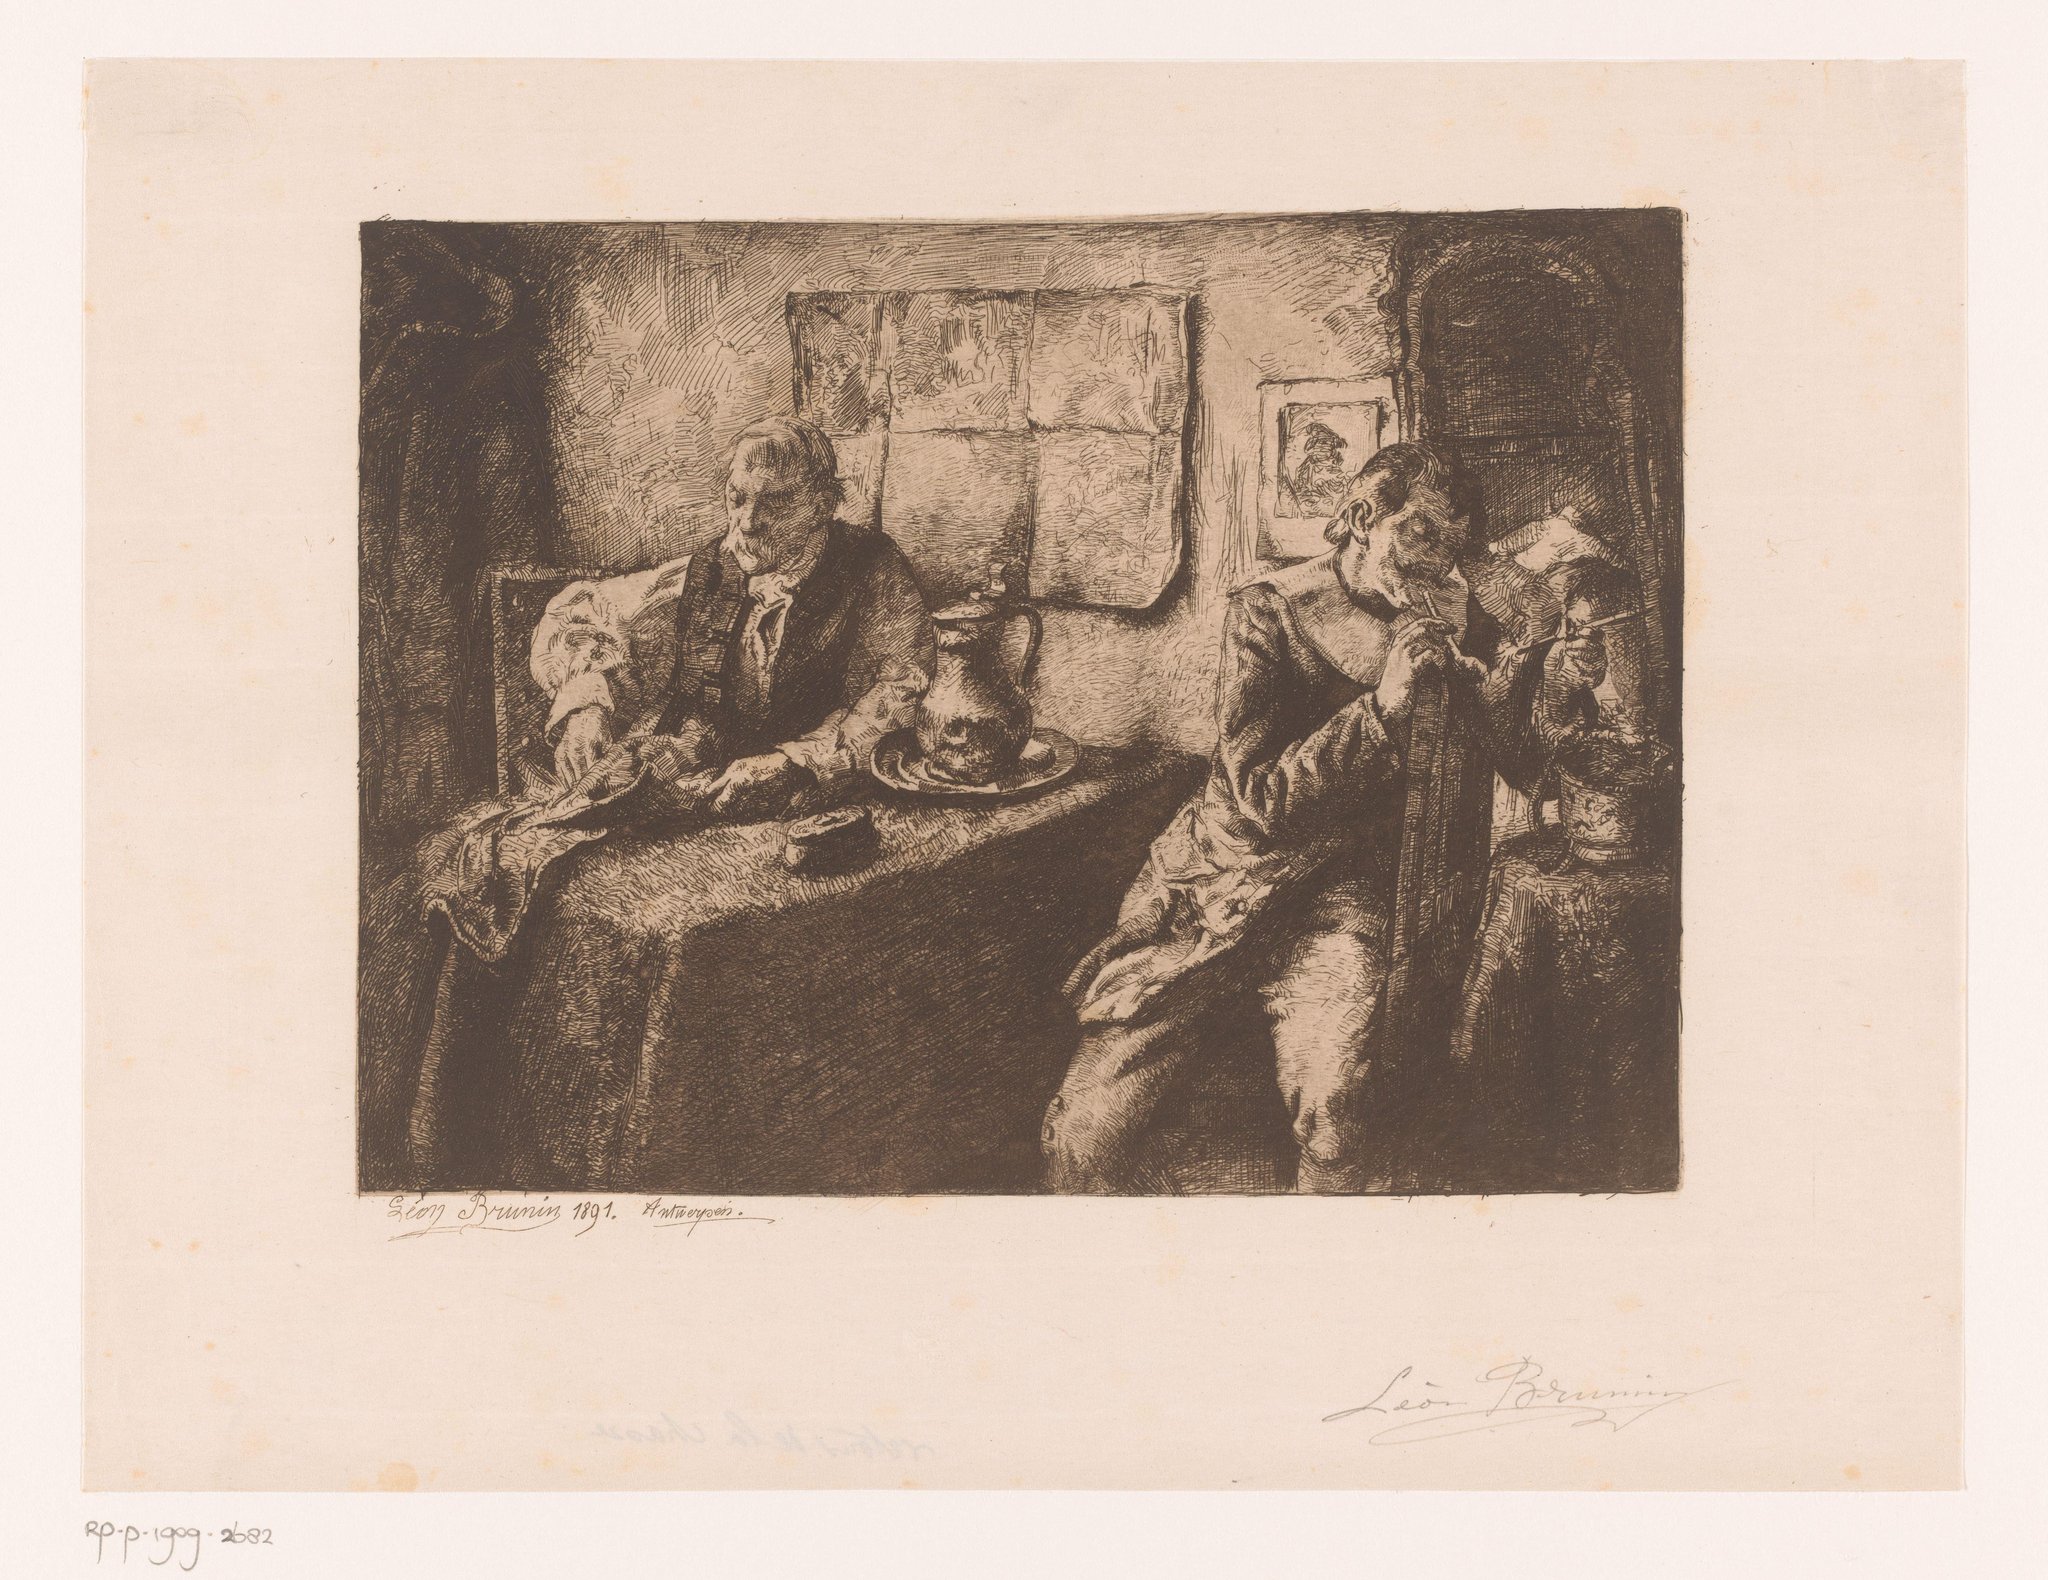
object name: print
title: Twee heren zitten aan tafel in een vertrek, één steekt zijn pijp aan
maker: léon brunin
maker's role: print maker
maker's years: 1861-1949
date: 1891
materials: paper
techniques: etching, intaglio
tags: pipe ~ tobacco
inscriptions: mark: ‘Antwerpsche Etsers 1880’, annotation: ‘Retour de la chasse’, collector's mark: Lugt 2228